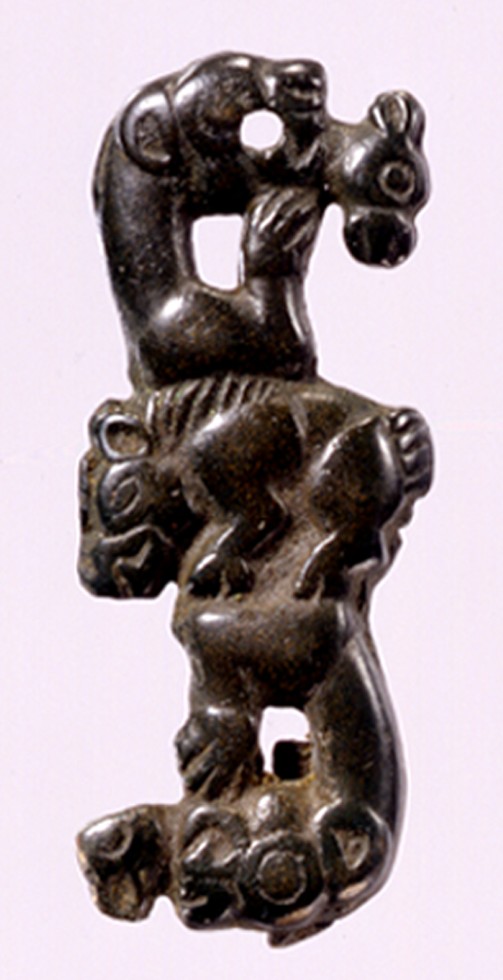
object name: garment plaque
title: Garment Plaque with Animal Motif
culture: northwest chinese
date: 500-301 BCE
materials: bronze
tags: animals